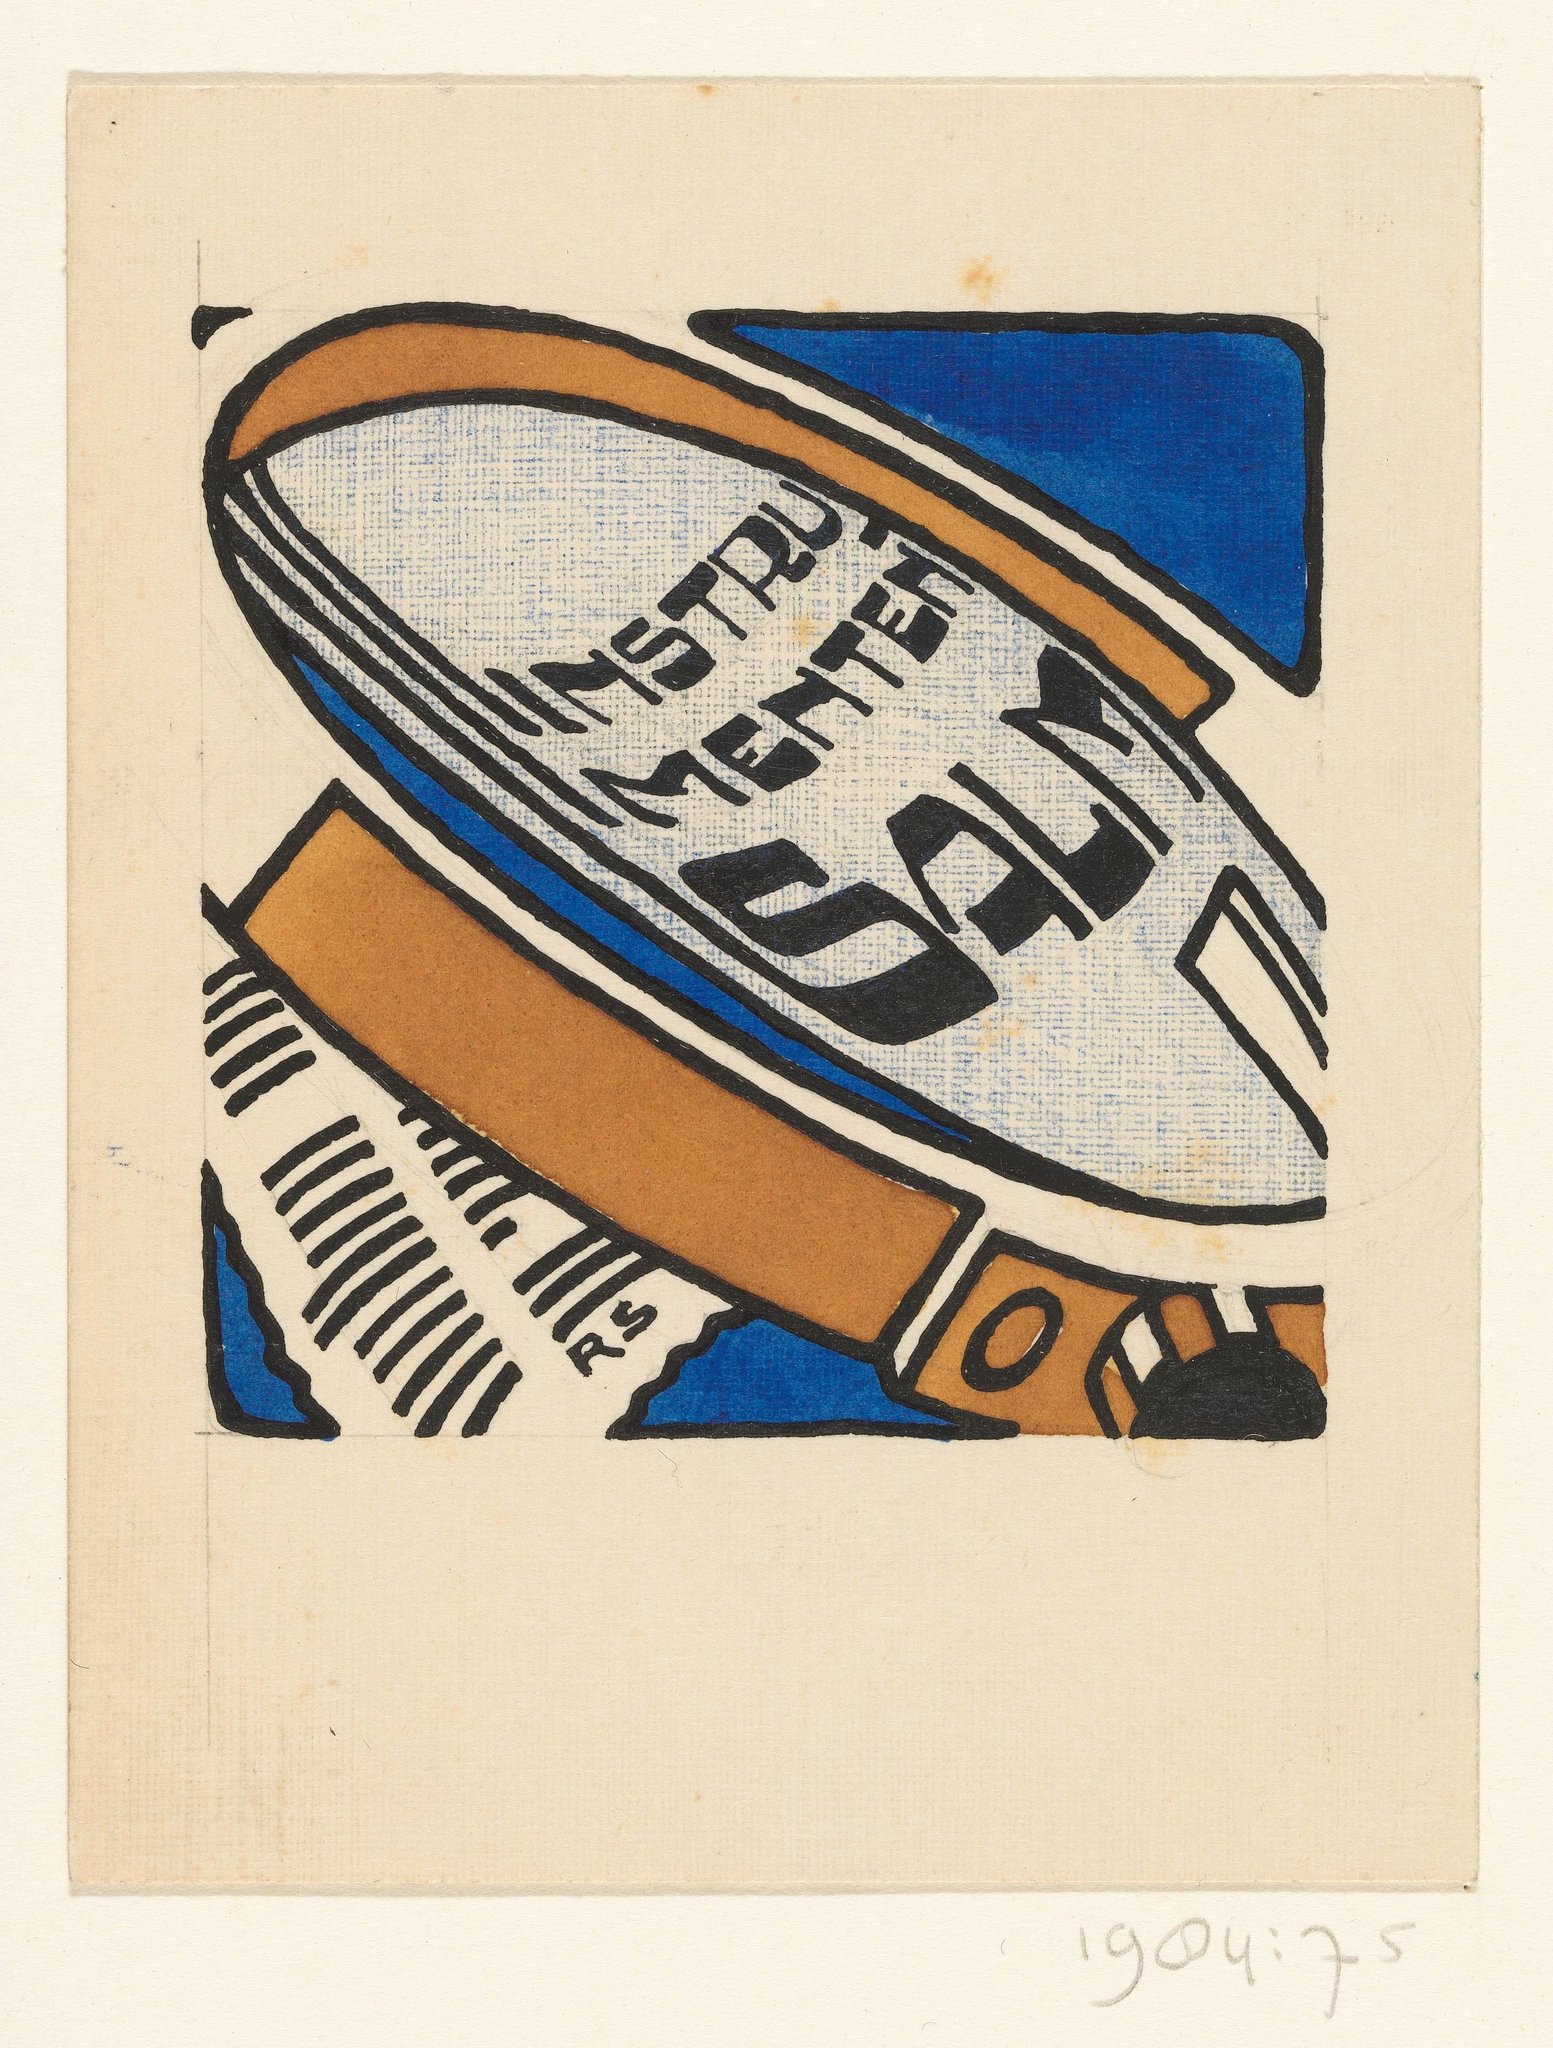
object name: drawing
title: Instrumenten Salm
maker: reijer stolk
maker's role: draughtsman, print maker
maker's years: 1896-1945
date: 1906-1945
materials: chalk, ink, paper, pencil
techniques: brush, pen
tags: names of organizations, companies, trade unions, etc., magnifying glass, advertisement, notice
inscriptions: collector's mark: Lugt 2760, collector's mark: Lugt 2228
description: Deze tekening is mogelijk een ontwerp voor een affiche.